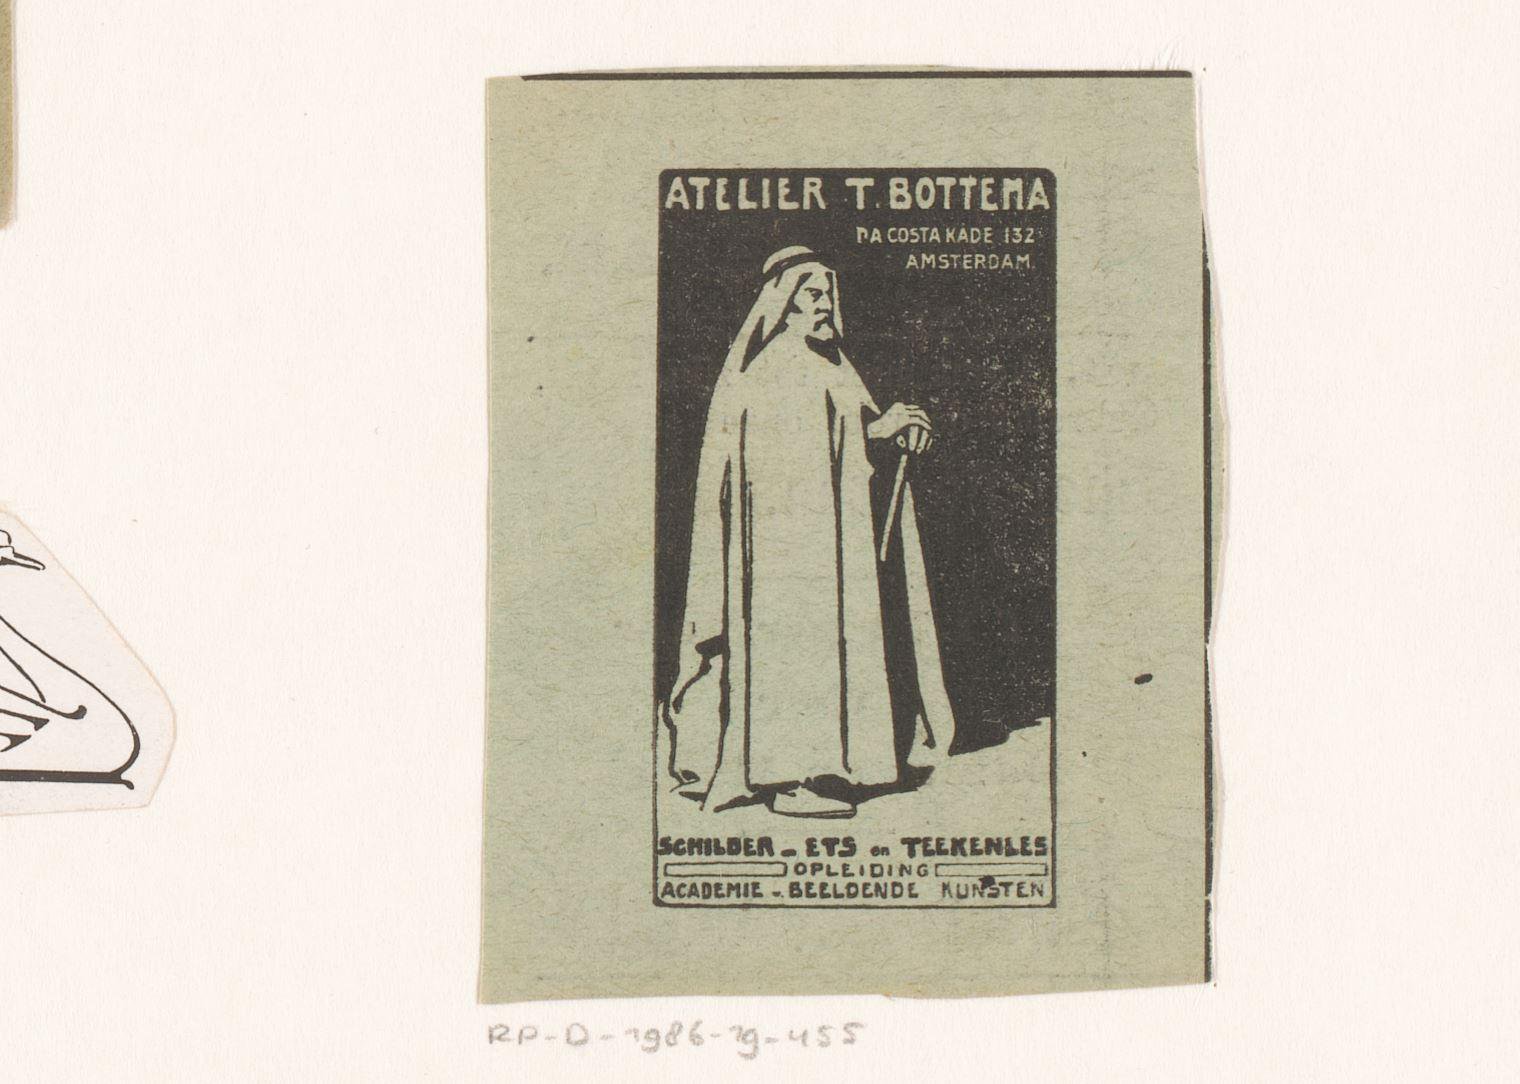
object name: photomechanical print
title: Advertentie voor schilder-, ets- en tekenles in Atelier T. Bottema te Amsterdam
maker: reinier willem petrus de vries (1874-1953)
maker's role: draughtsman, print maker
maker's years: 1874-1953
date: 1884-1952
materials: paper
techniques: printing block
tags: english channel, print maker, draughtsman, tjerk bottema, standing figure, walking-stick, staff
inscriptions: collector's mark: ‘R:MVS.’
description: Staande man in lang gewaad met een wandelstok.